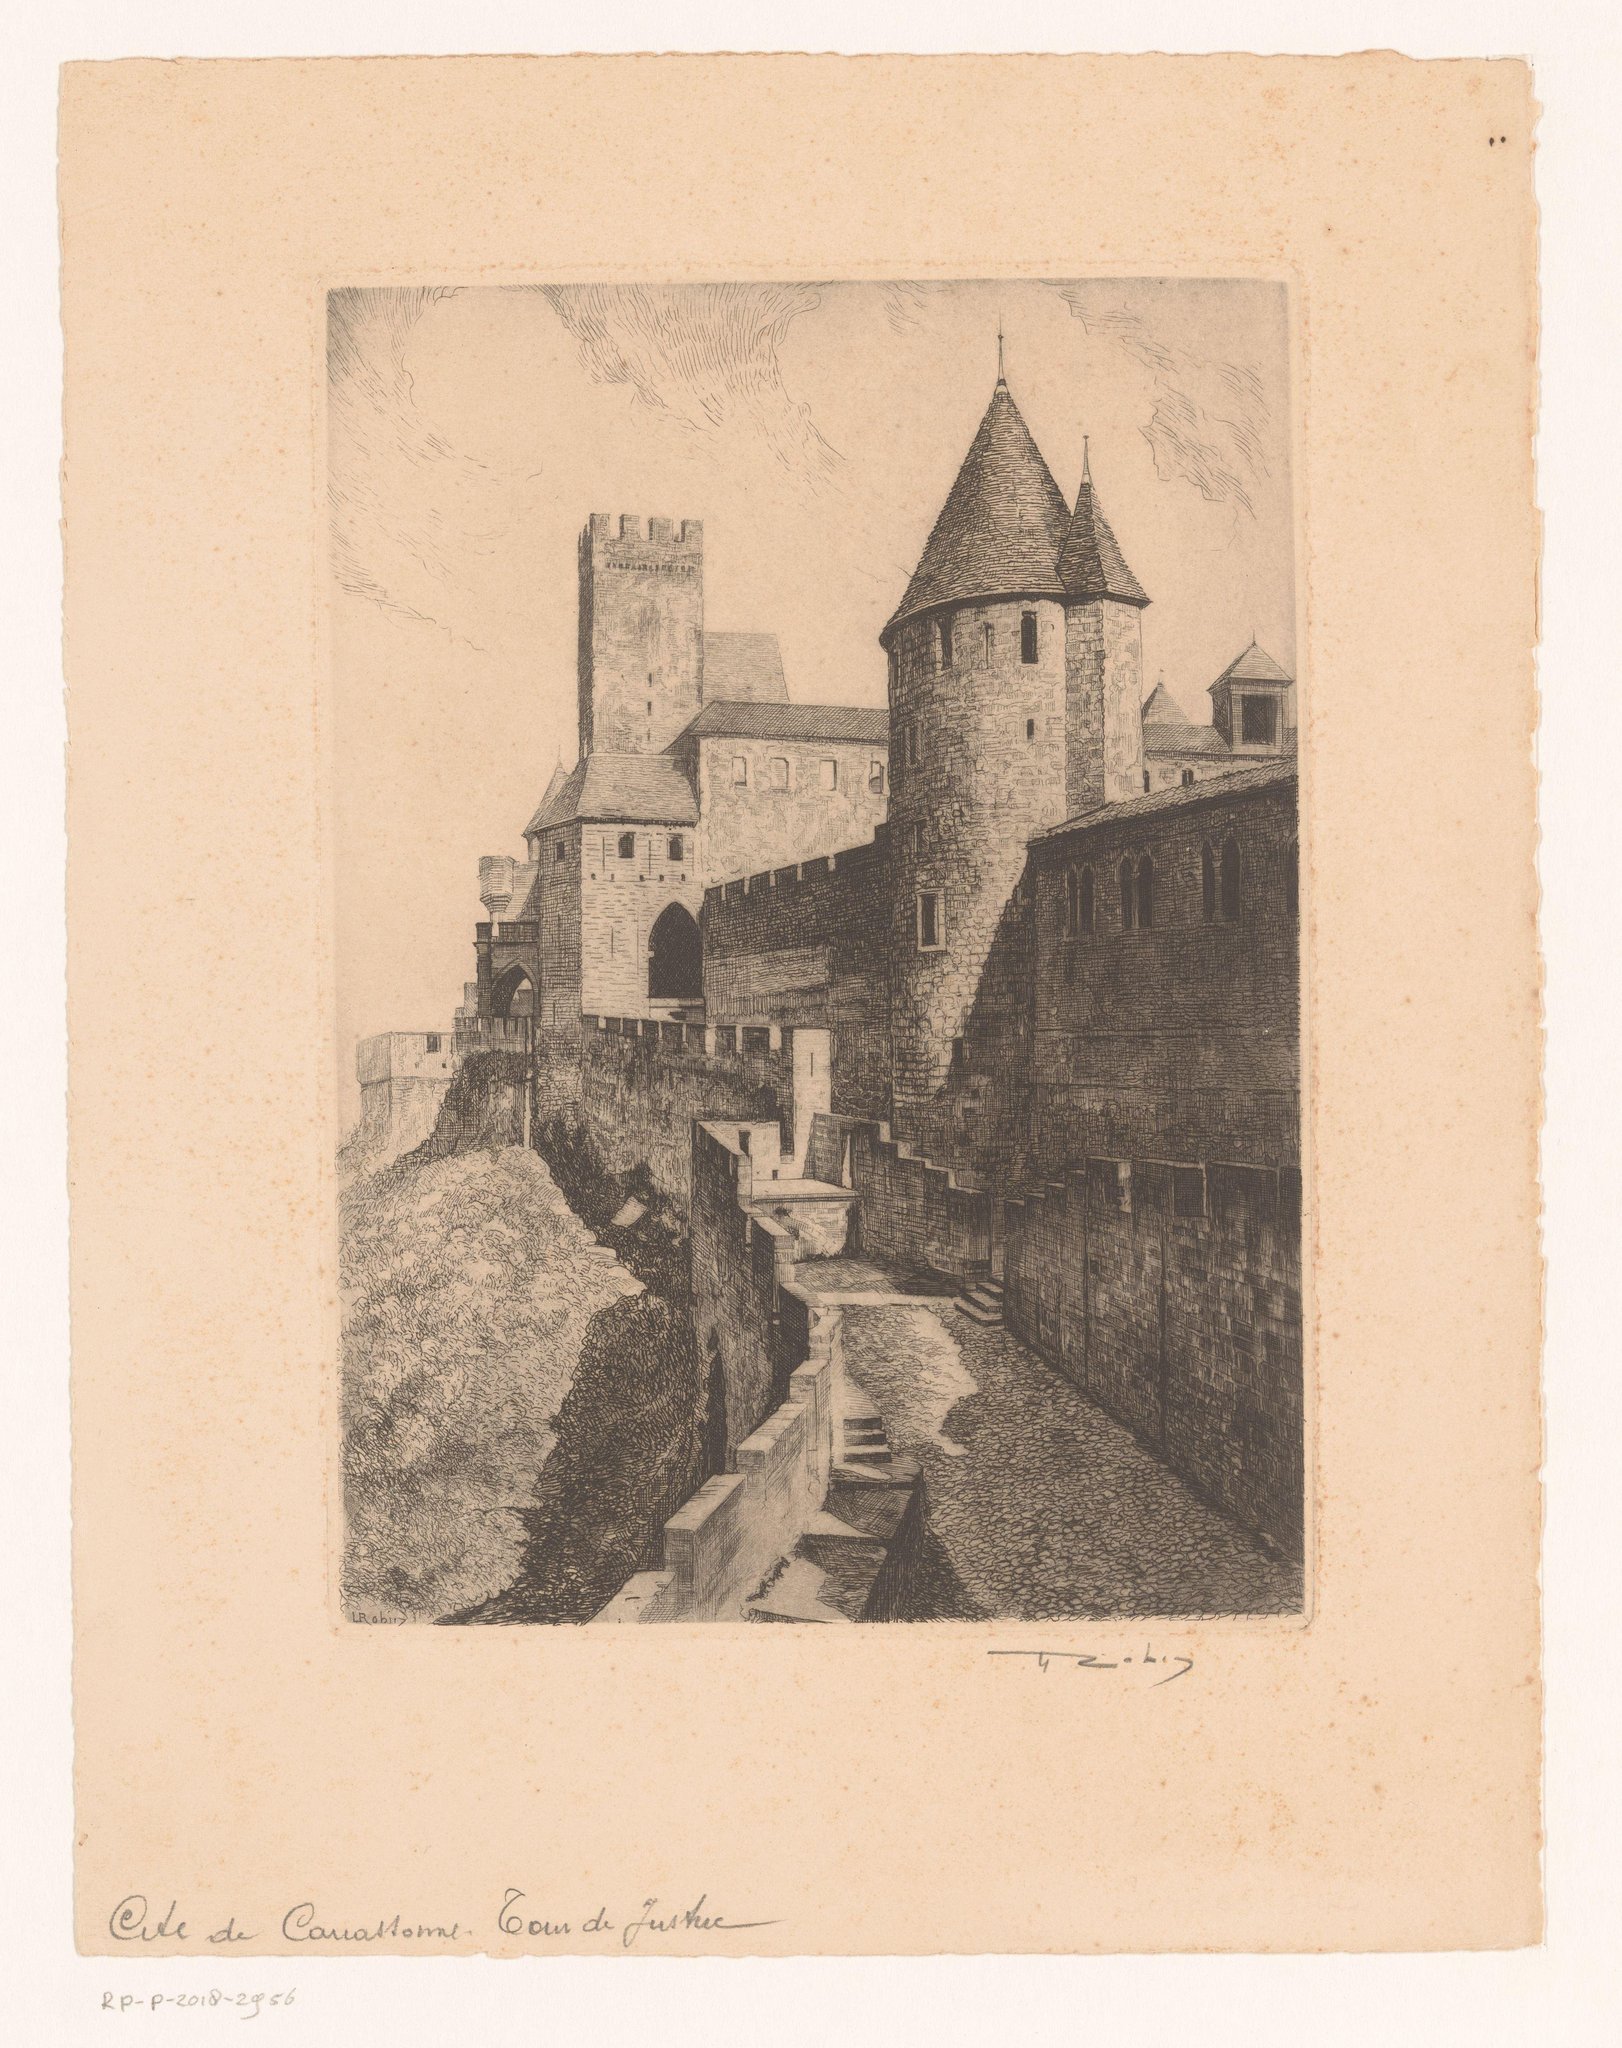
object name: print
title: Carcassonne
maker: léopold robin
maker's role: print maker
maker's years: 1877-1939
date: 1887-1939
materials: paper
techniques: etching, intaglio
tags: landscape with tower or castle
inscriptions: inscription: ‘Robin / Cite de Carcassonne tour de Justice’, collector's mark: Lugt 2228